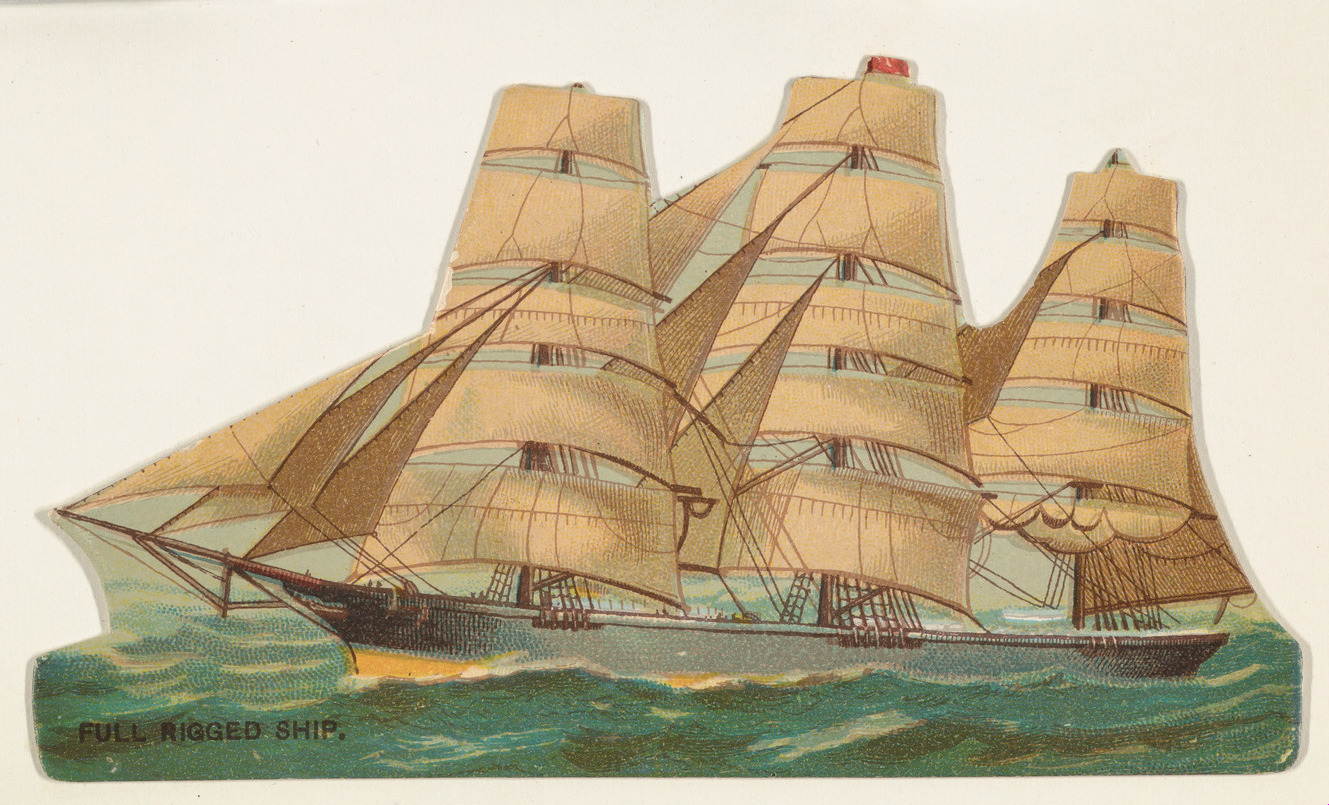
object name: print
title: Full Rigged Ship, from the Types of Vessels series (N139) issued by Duke Sons & Co. to promote Honest Long Cut Tobacco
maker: w. duke, sons & co.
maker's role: publisher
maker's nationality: american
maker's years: 1870-1920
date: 1889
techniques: color lithograph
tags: ships